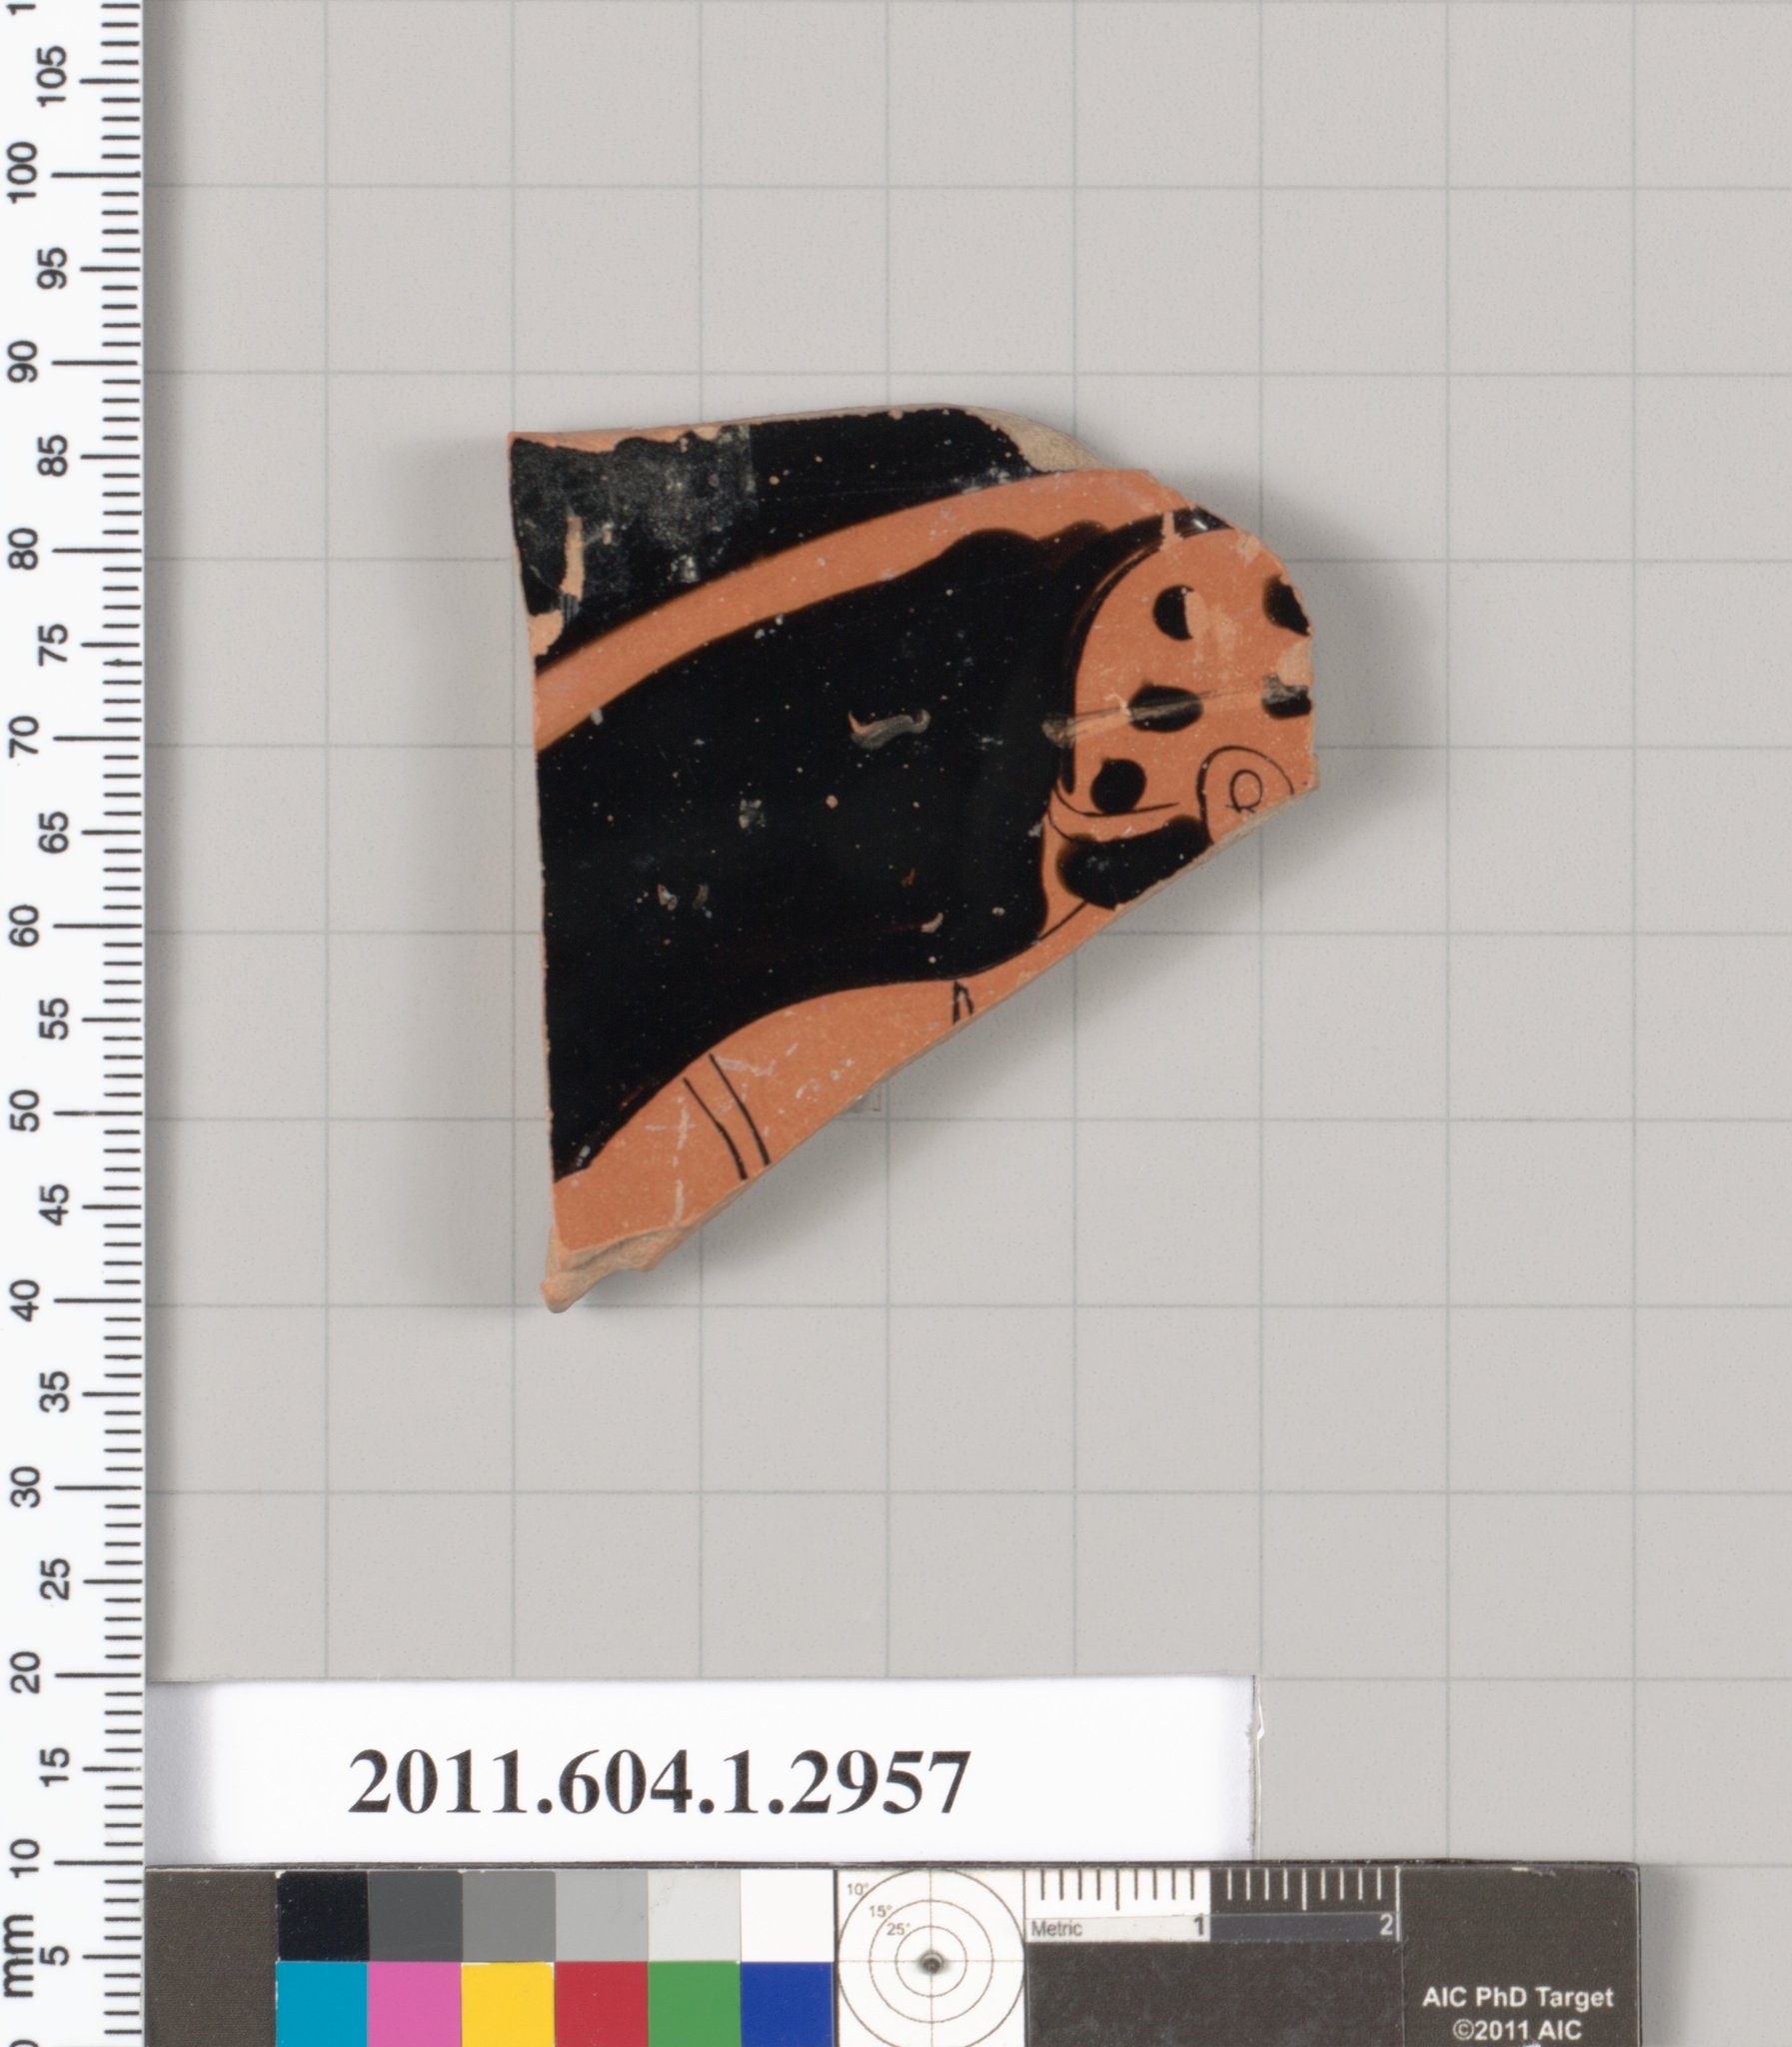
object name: kylix fragment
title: Terracotta fragment of a kylix (drinking cup)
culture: greek, attic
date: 490-470 BCE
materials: terracotta